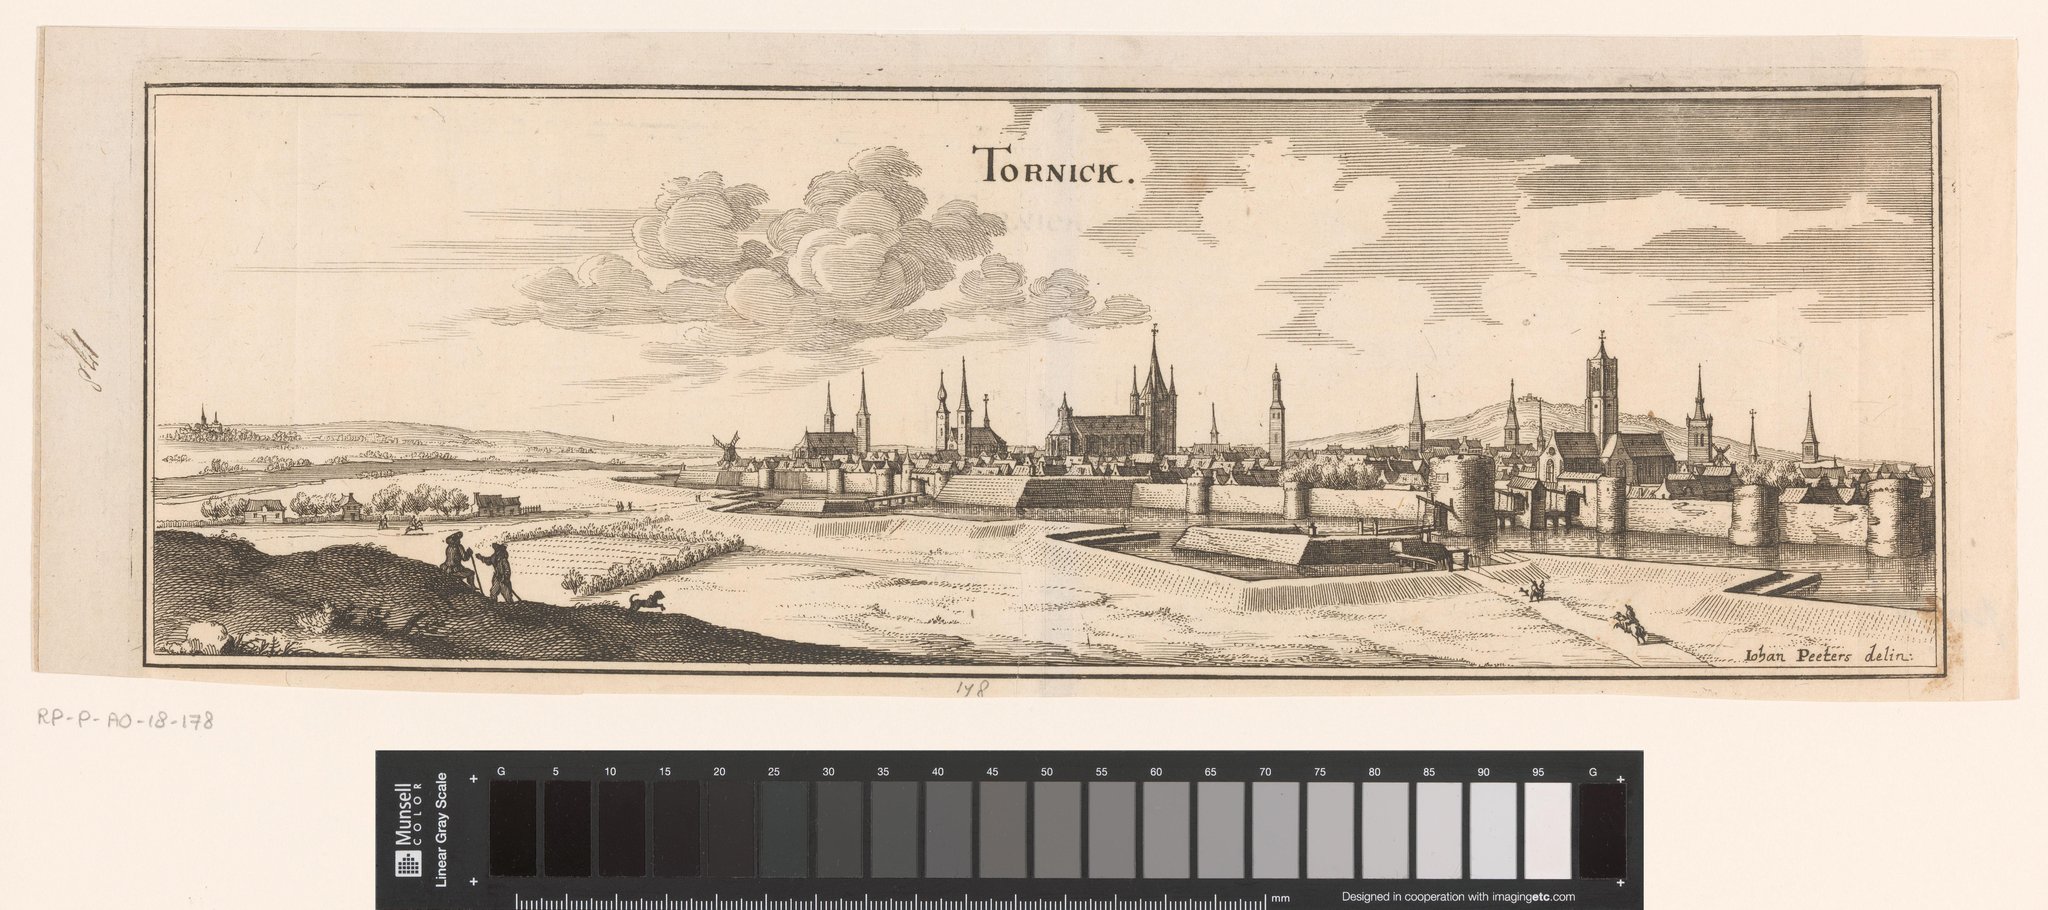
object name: print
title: Gezicht op Doornik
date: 1654-1700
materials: paper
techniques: engraving, etching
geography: frankfurt am main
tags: church (exterior), prospect of city, town panorama, silhouette of city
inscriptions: collector's mark: Lugt 2228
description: Prent gebruikt in: Zeiller, Martin. M.Z. Topographia Circuli Burgundici Oder Beschreibung une Eigentliche Abbildung der Vornehmsten Örter in dem Hochlöblichen Burgund- un Niderlandischen Crayse. Frankfurt am Main: Caspar Merian, 1654. Of in: Zeiller, Martin. M. Z. Topographia Germaniae-Inferioris vel Circuli-Burgundici, das ist Beschreibung (…). Frankfurt am Main: Caspar Merian, 1659. Of in een van de twee latere uitgaven van deze publicatie die, hoewel het jaar 1659 erin staat vermeld als jaar van uitgave, zijn uitgegeven in respectievelijk ca. 1670 en ca. 1700.